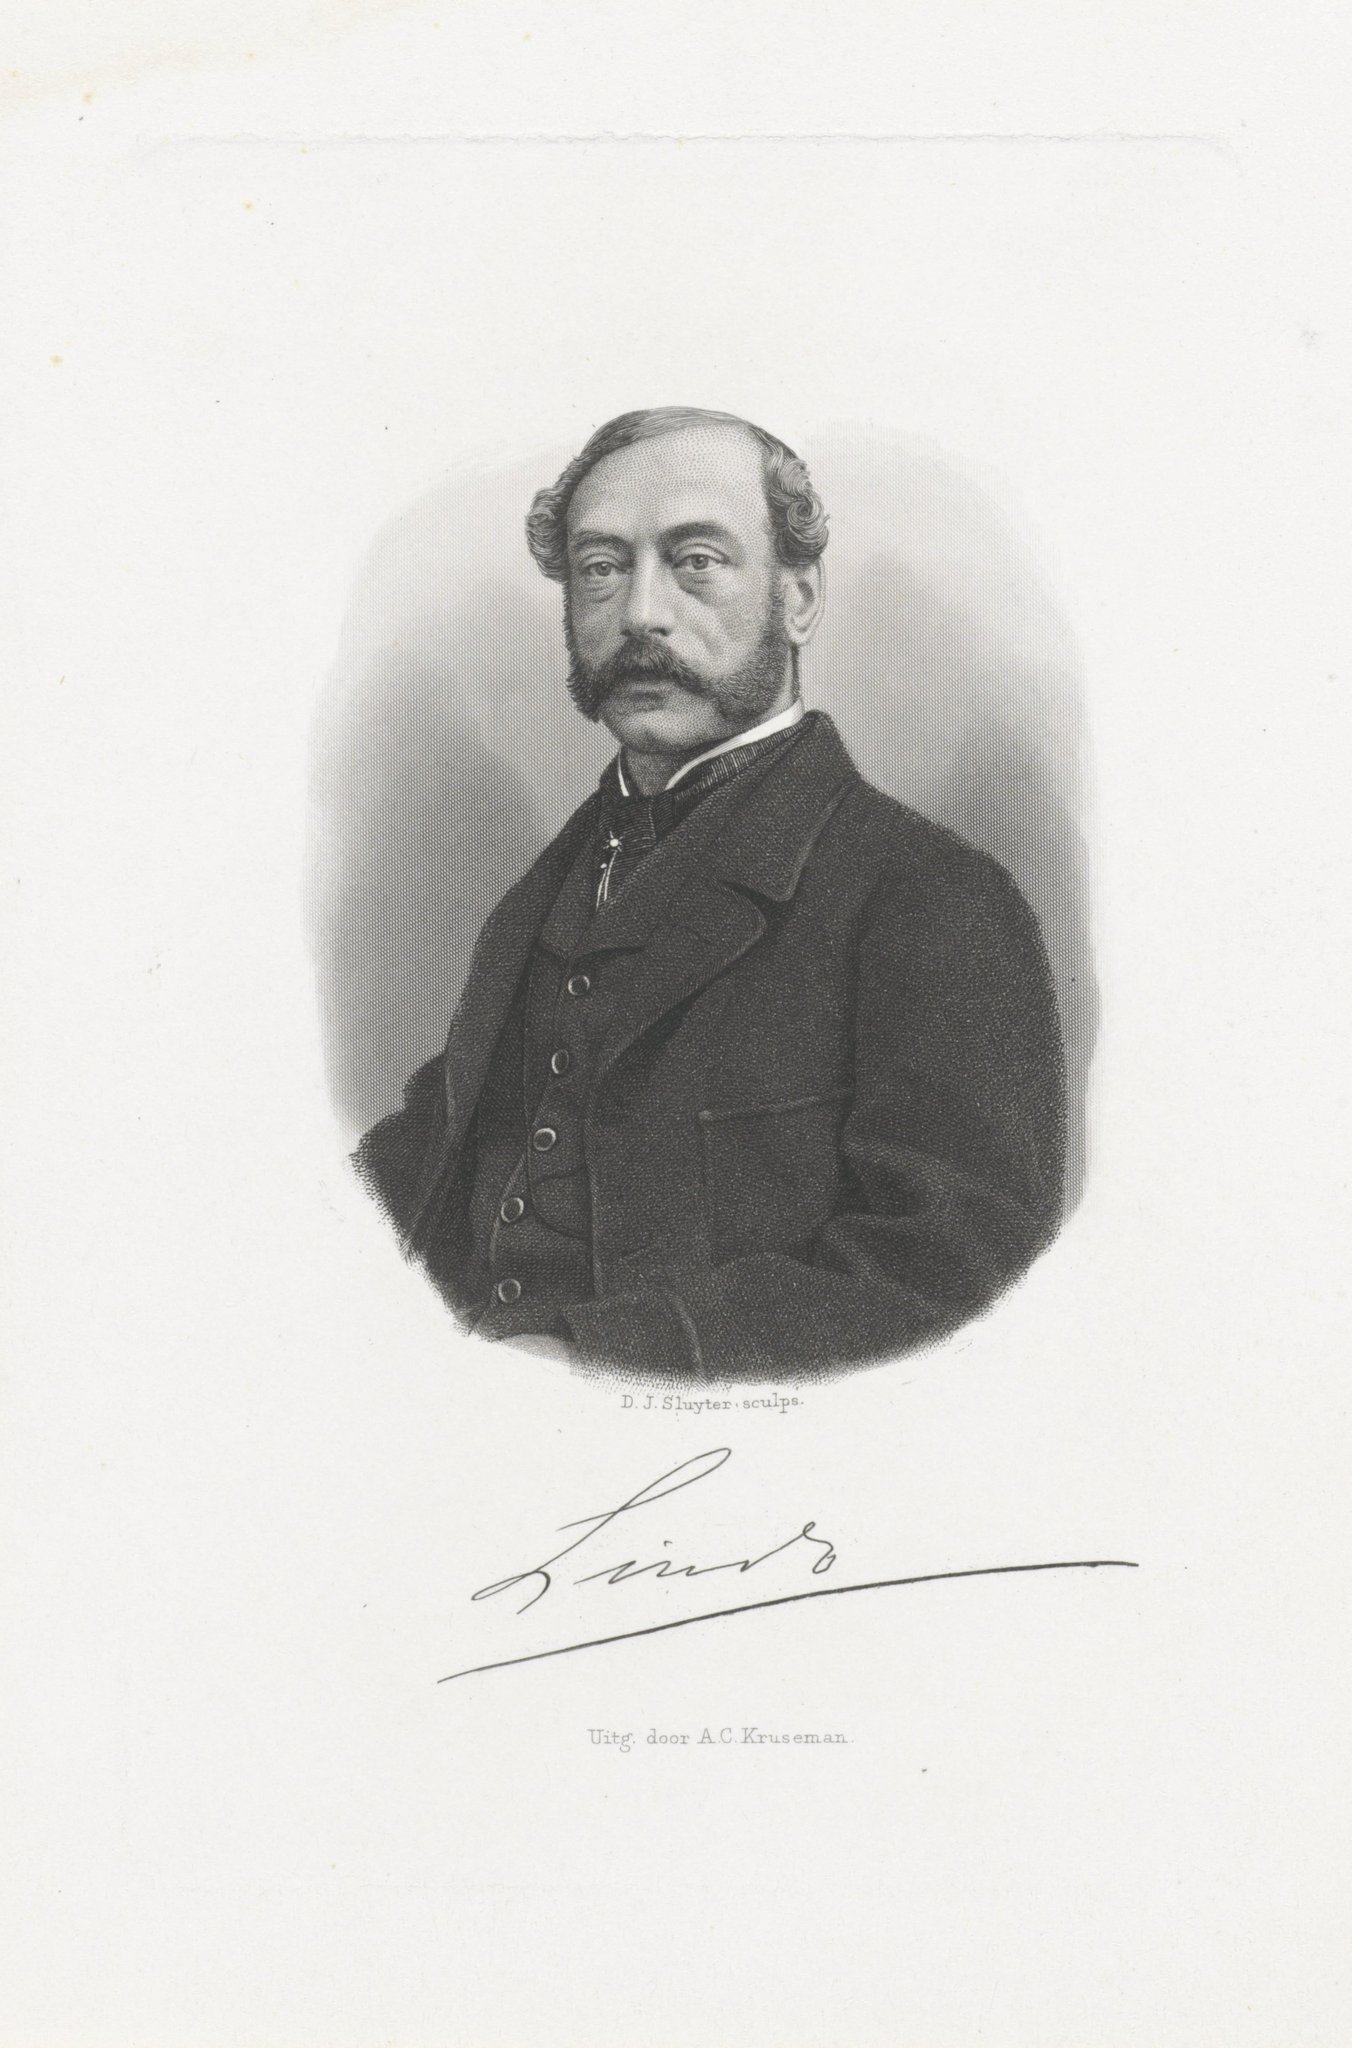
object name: print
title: Portret van Lintz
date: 1826-1886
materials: paper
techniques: etching, engraving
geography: haarlem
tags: lintz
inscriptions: collector's mark: Lugt 2228